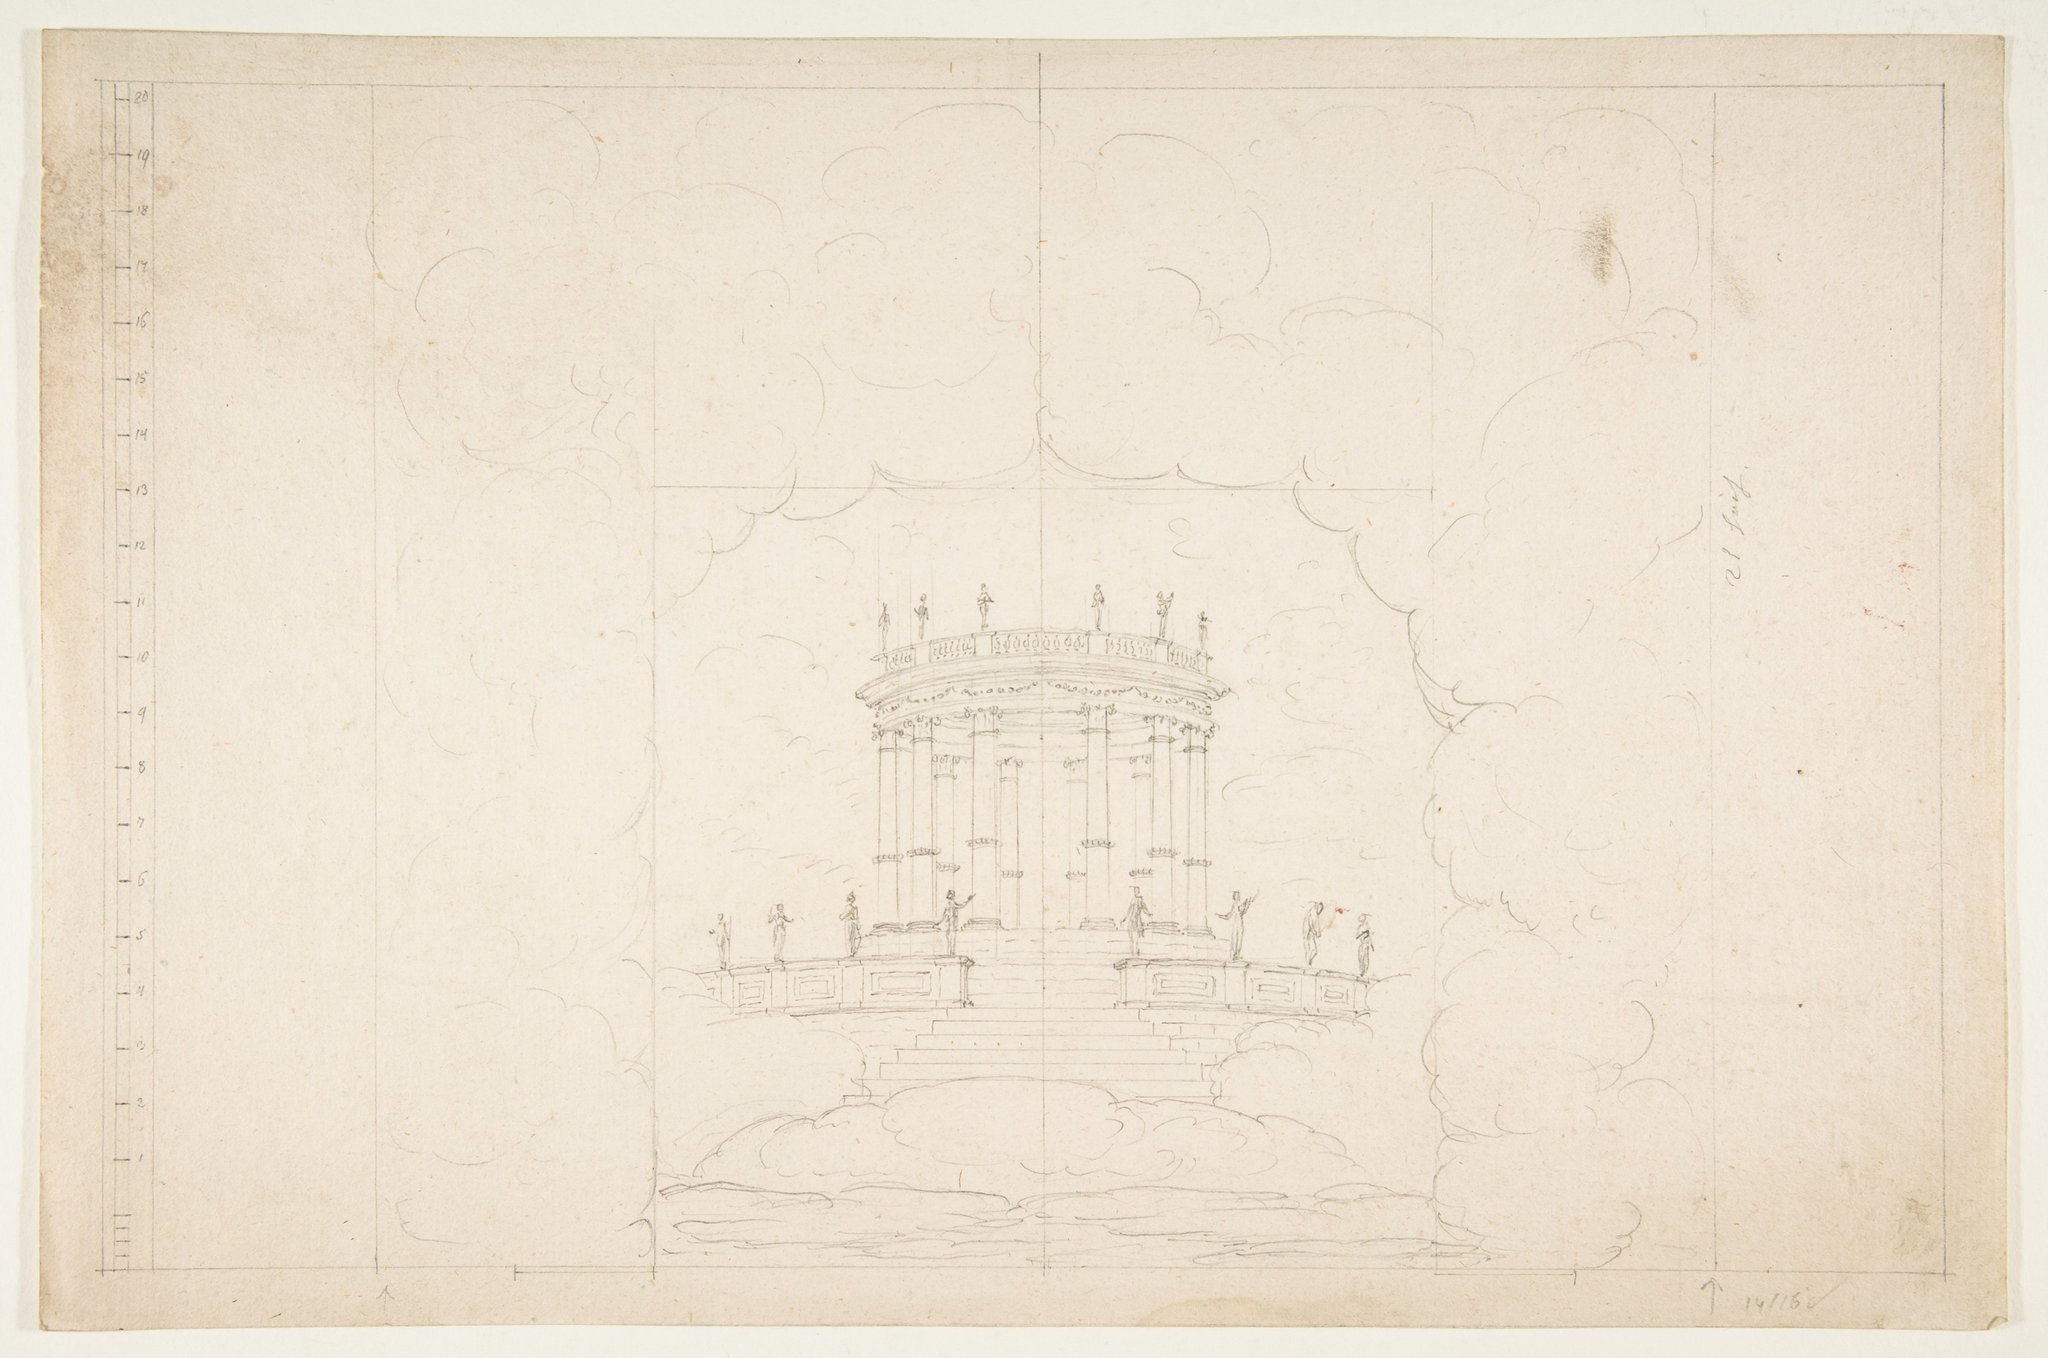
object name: drawing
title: Design for a Stage Set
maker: anonymous, french, 19th century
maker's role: artist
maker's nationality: french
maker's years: 1800-1900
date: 1801-1900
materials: graphite, paper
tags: stage design